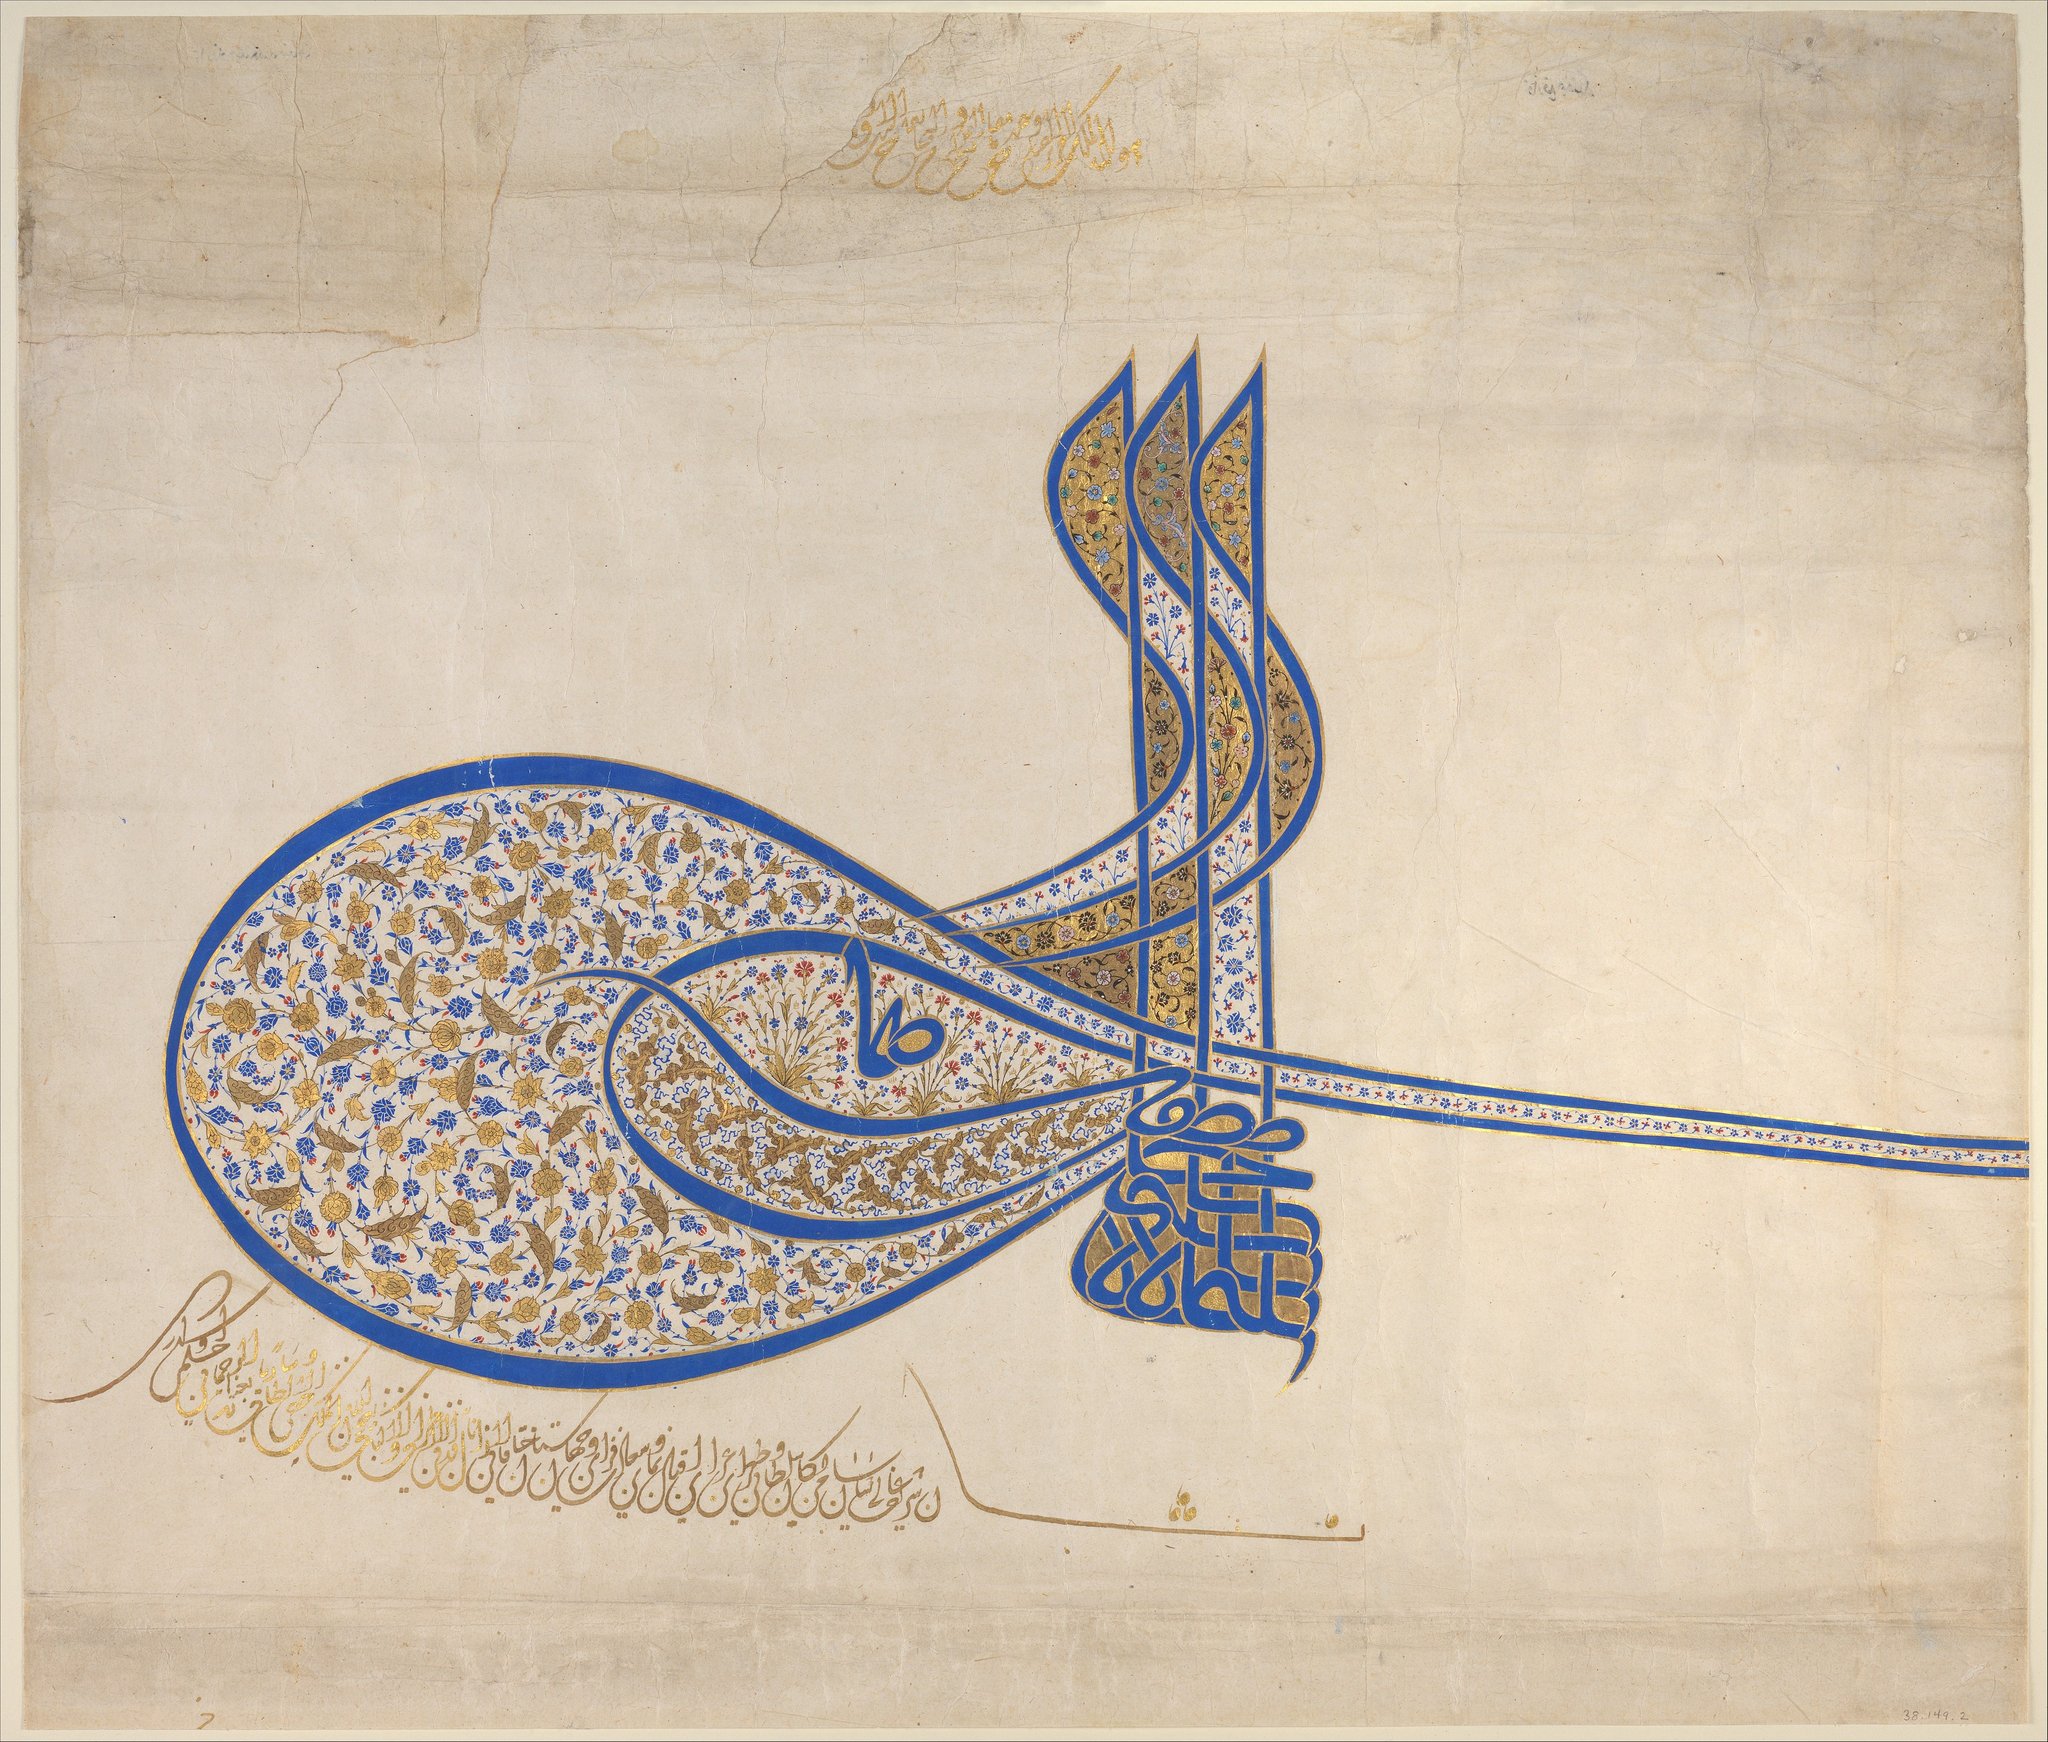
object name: tughra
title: Tughra (Insignia) of Sultan Süleiman the Magnificent (r. 1520–66)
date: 1555-1560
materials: gold, ink, paper, watercolor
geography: turkey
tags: insignia